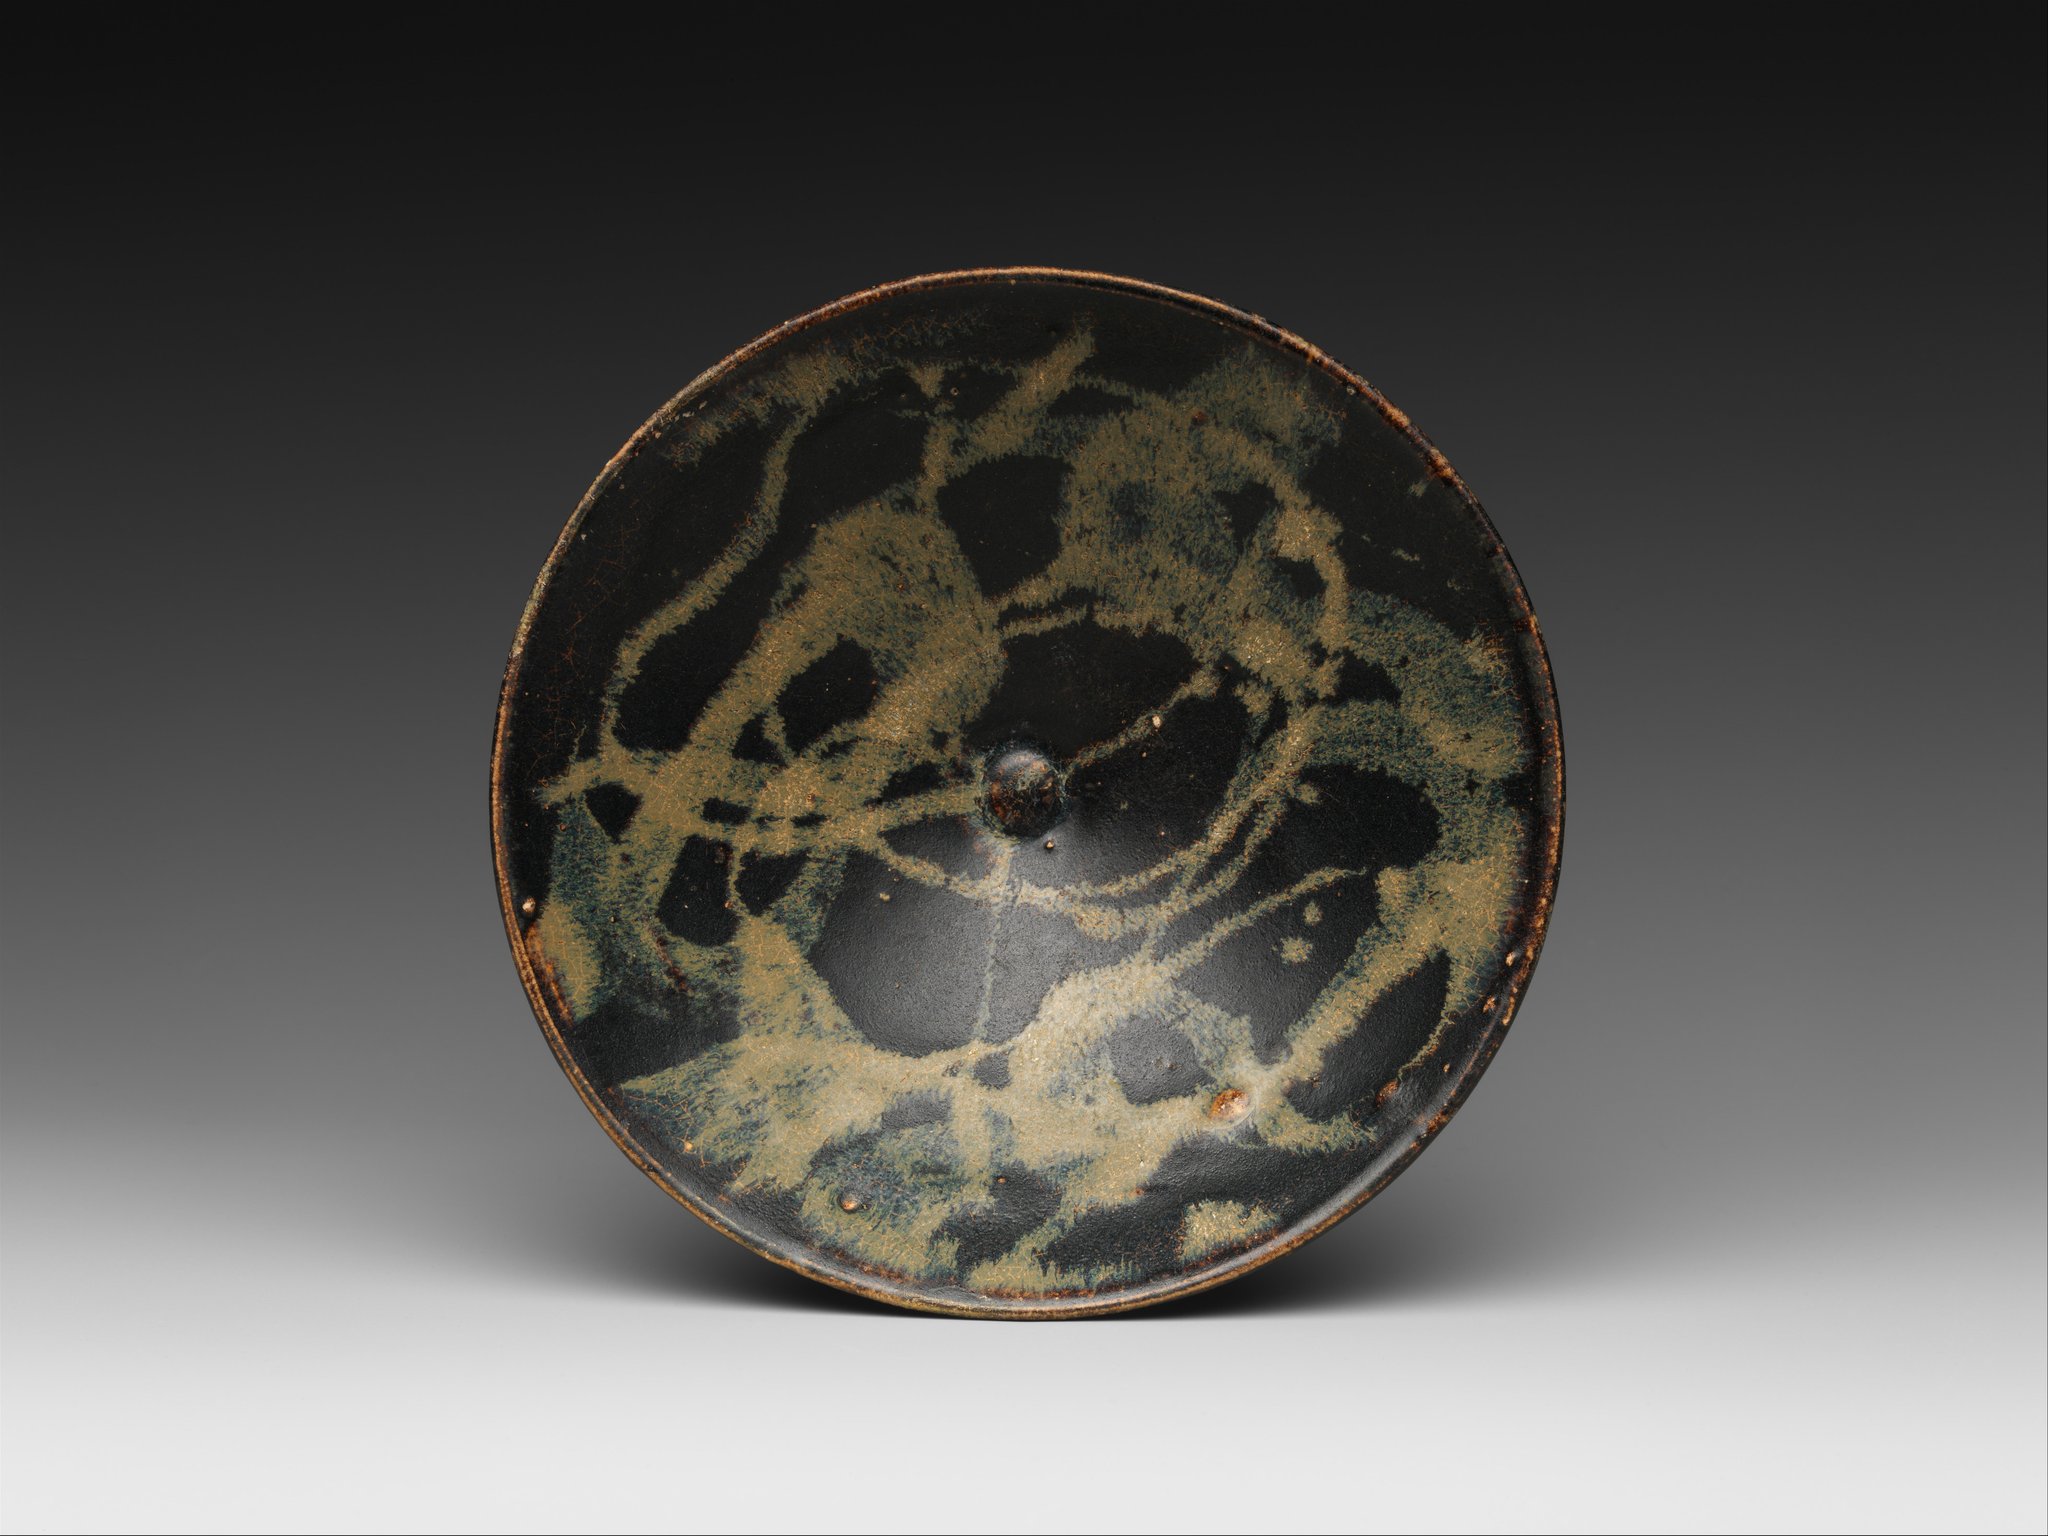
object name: tea bowl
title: Tea Bowl with Splashed Decoration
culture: chinese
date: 1101-1300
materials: glaze, stoneware